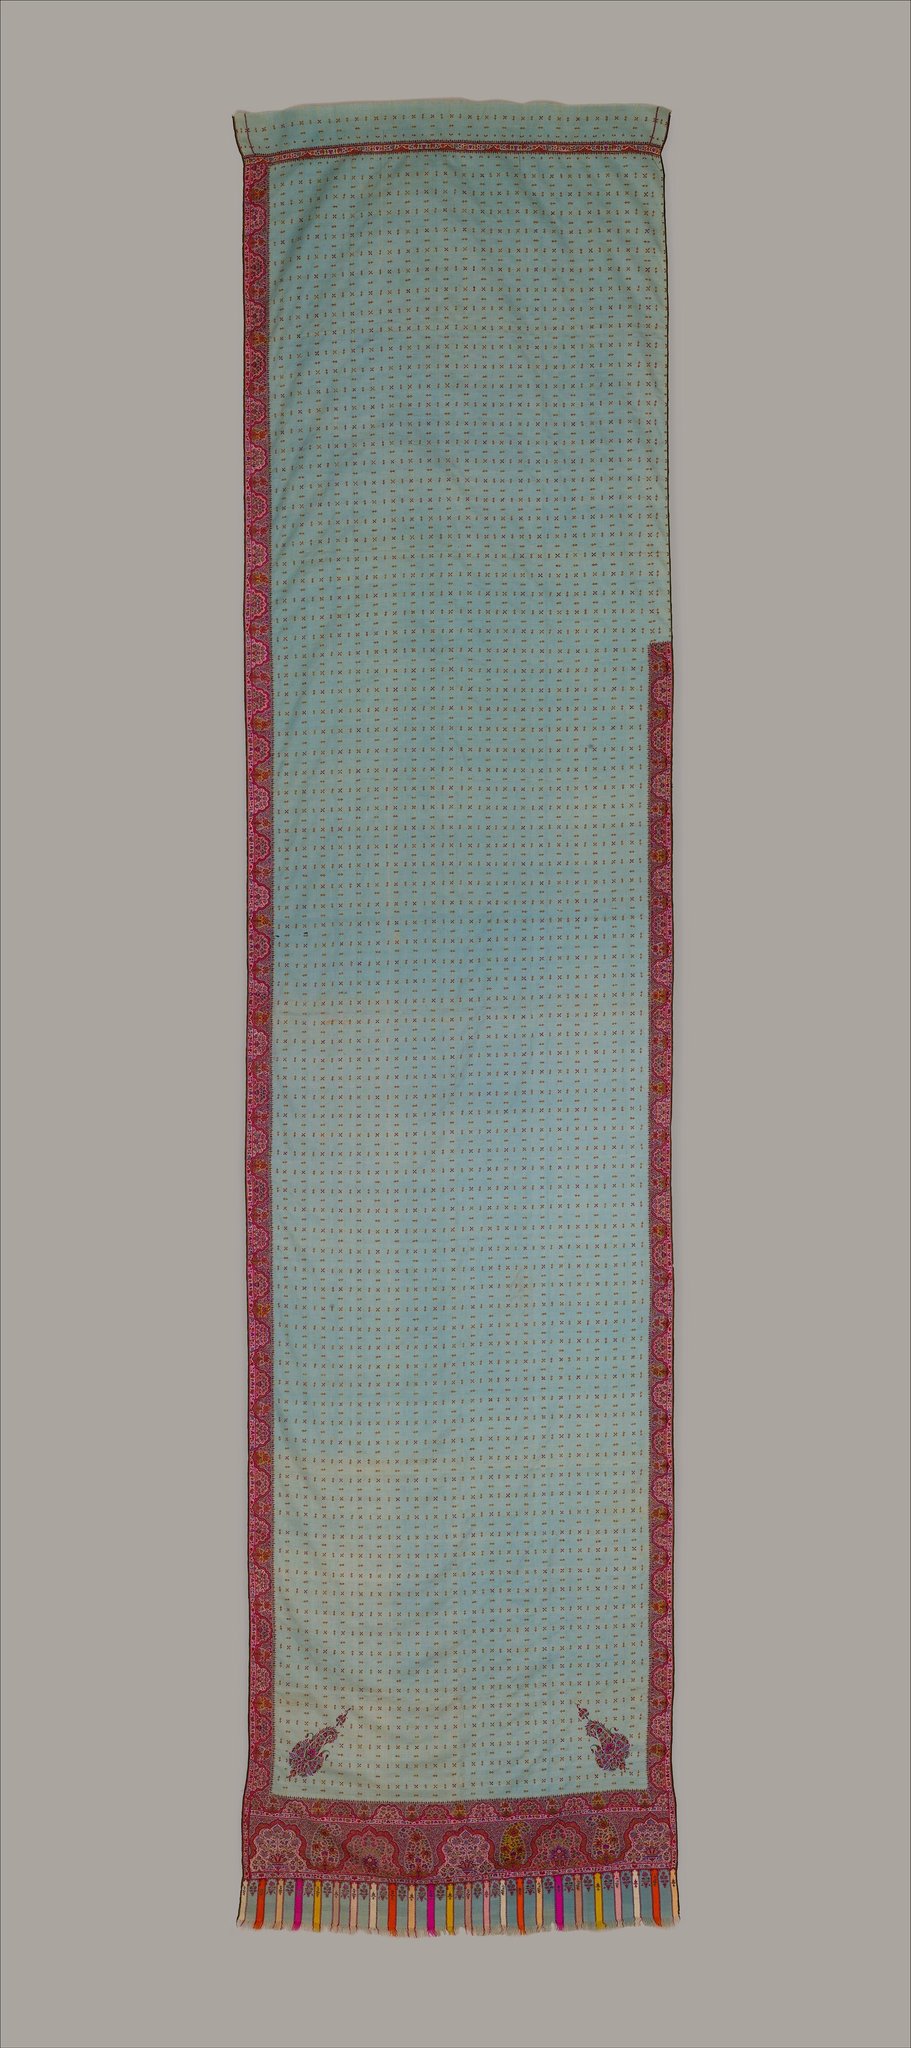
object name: sari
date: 1801-1833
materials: wool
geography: india